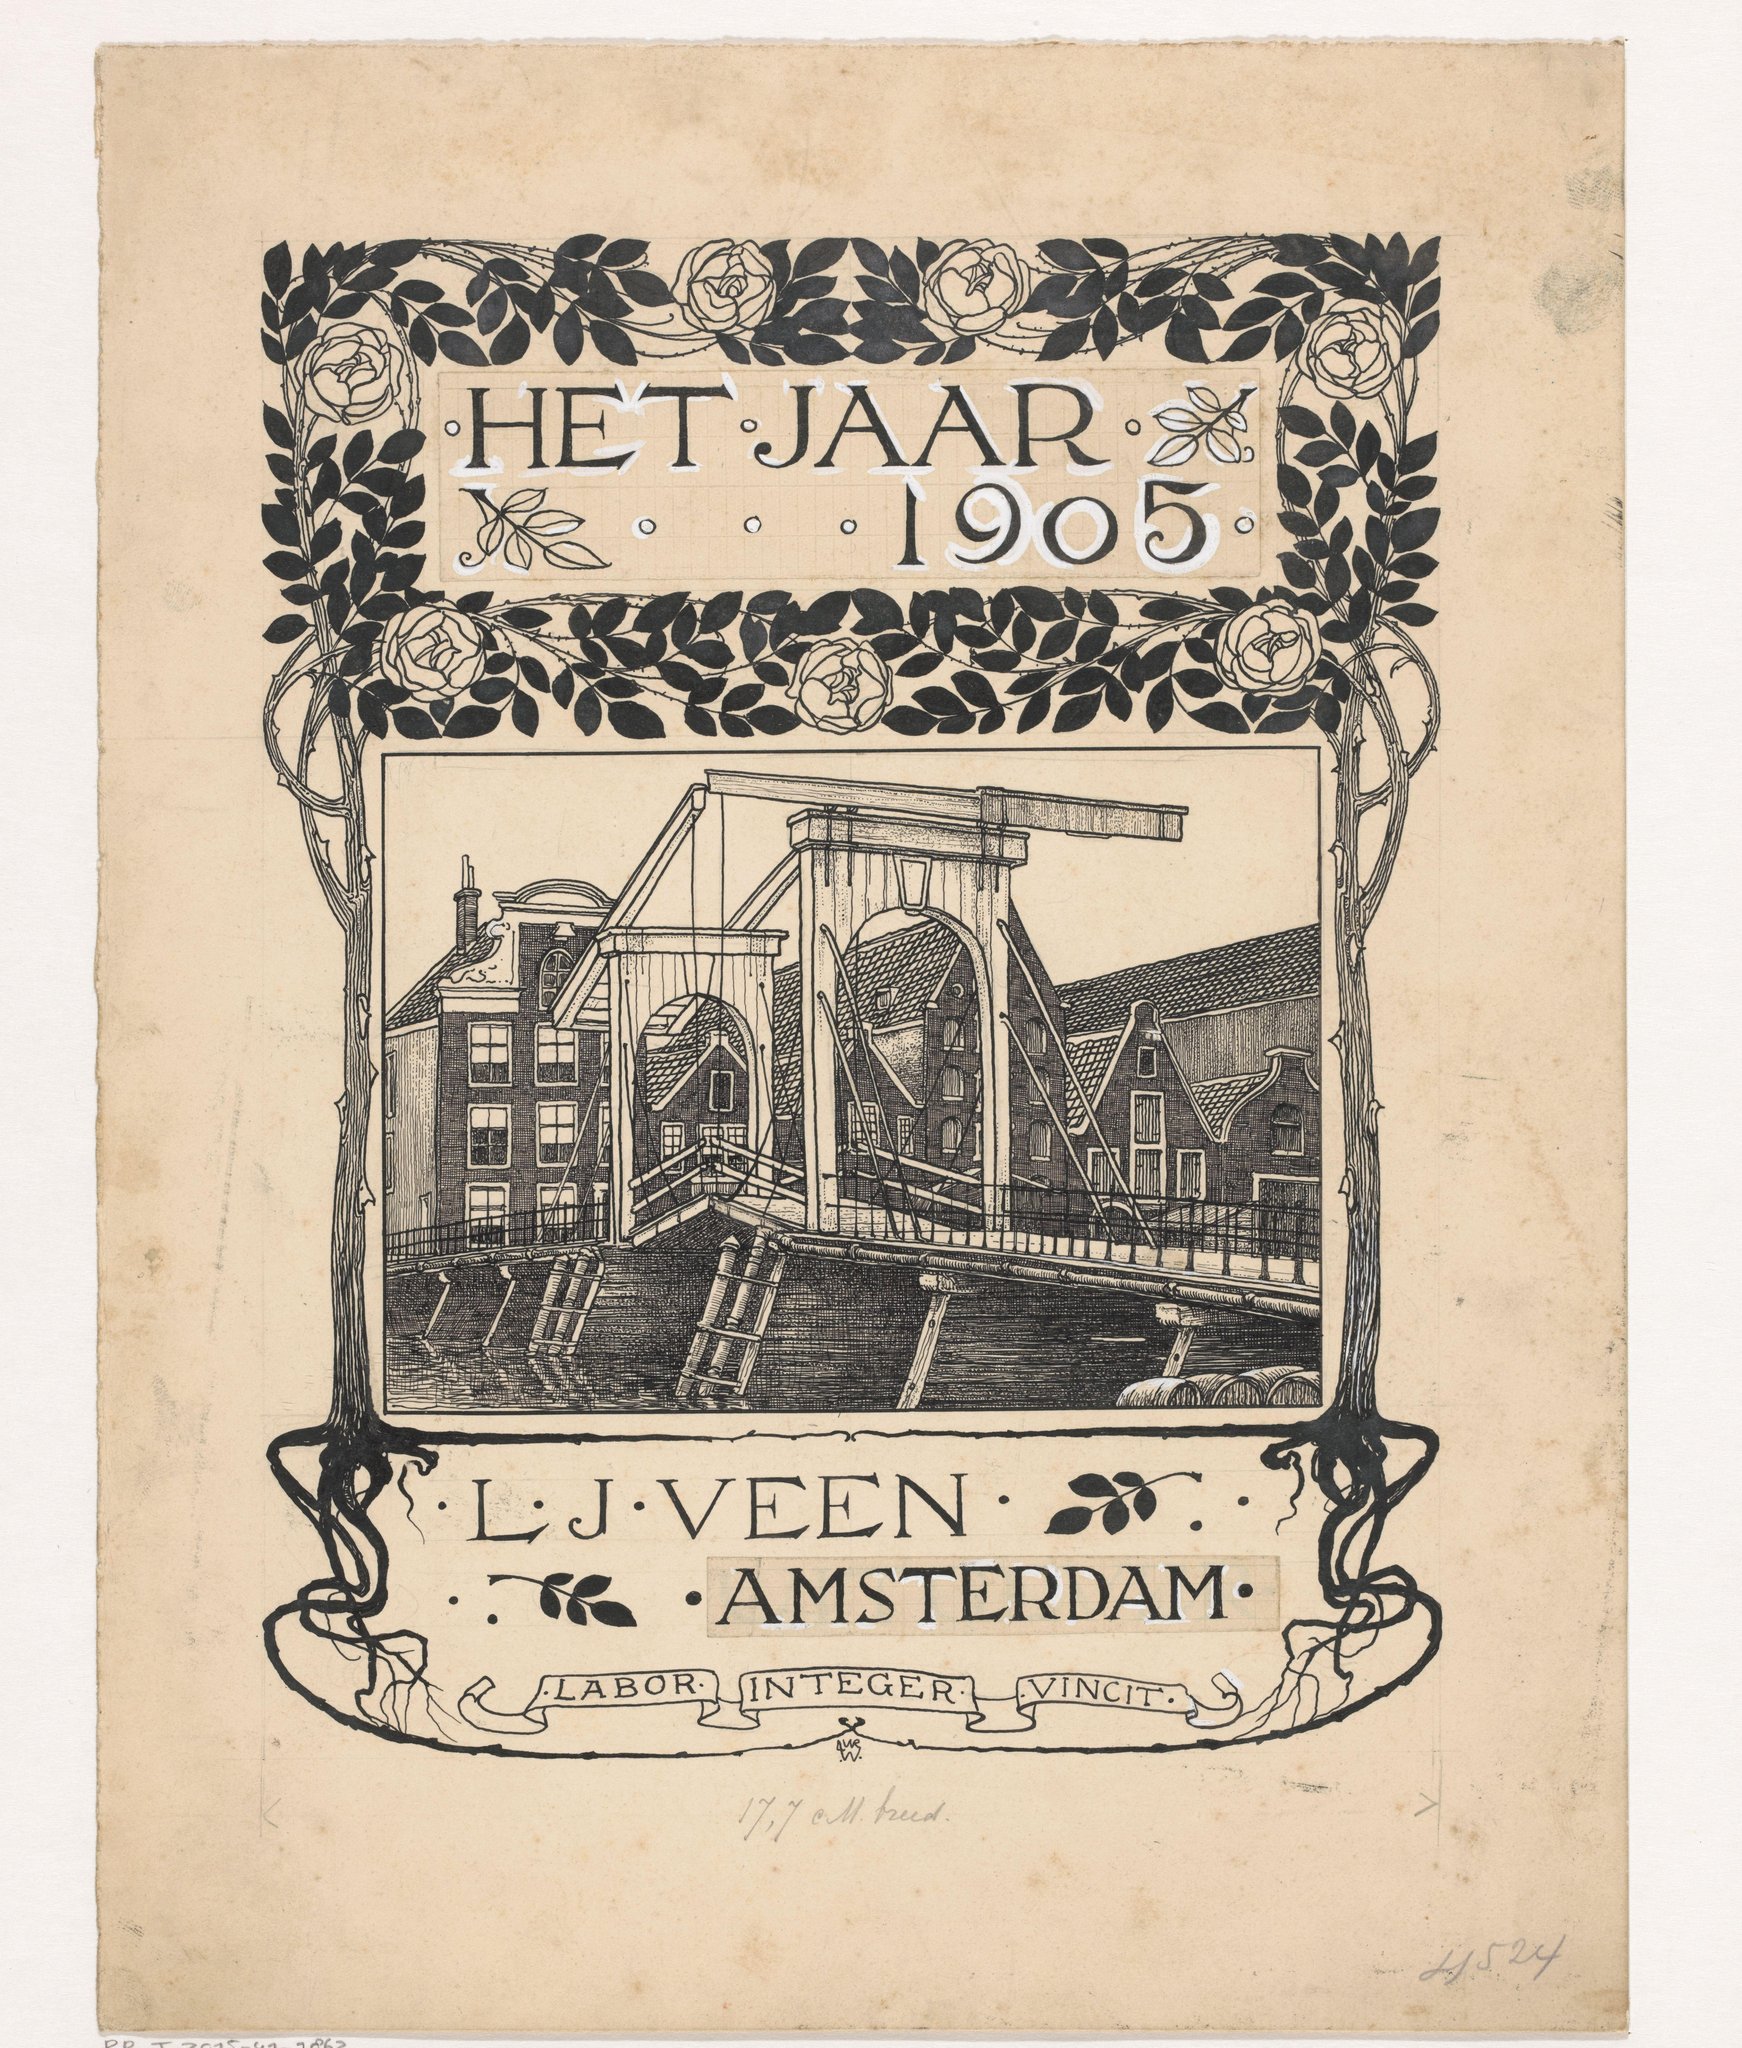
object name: drawing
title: Omslagontwerp voor: Het jaar 1905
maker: willem wenckebach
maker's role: designer, draughtsman, painter, print maker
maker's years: 1860-1937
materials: paint, ink, paper, pencil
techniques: brush, pen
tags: canals, waters (in city), flowers ~ ornament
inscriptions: collector's mark: Lugt 2228, monogram:, :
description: Gezicht op een ophaalbrug over een kanaal. In de achtergrond zijn rijtjeshuizen met verschillende gevels te zien. Onder de voorstelling de vermelding van Uitgeversmaatschappij L.J. Veen en de spreuk 'Labor Integer Vincit' in drie spreukbanden. Aan weerszijden hiervan de wortels en stammen van een rozenstruik die langs de voorstelling omhoog groeien en daarboven een motief vormen van rozen en bladeren die de tekst 'Het jaar 1905' omsluiten.